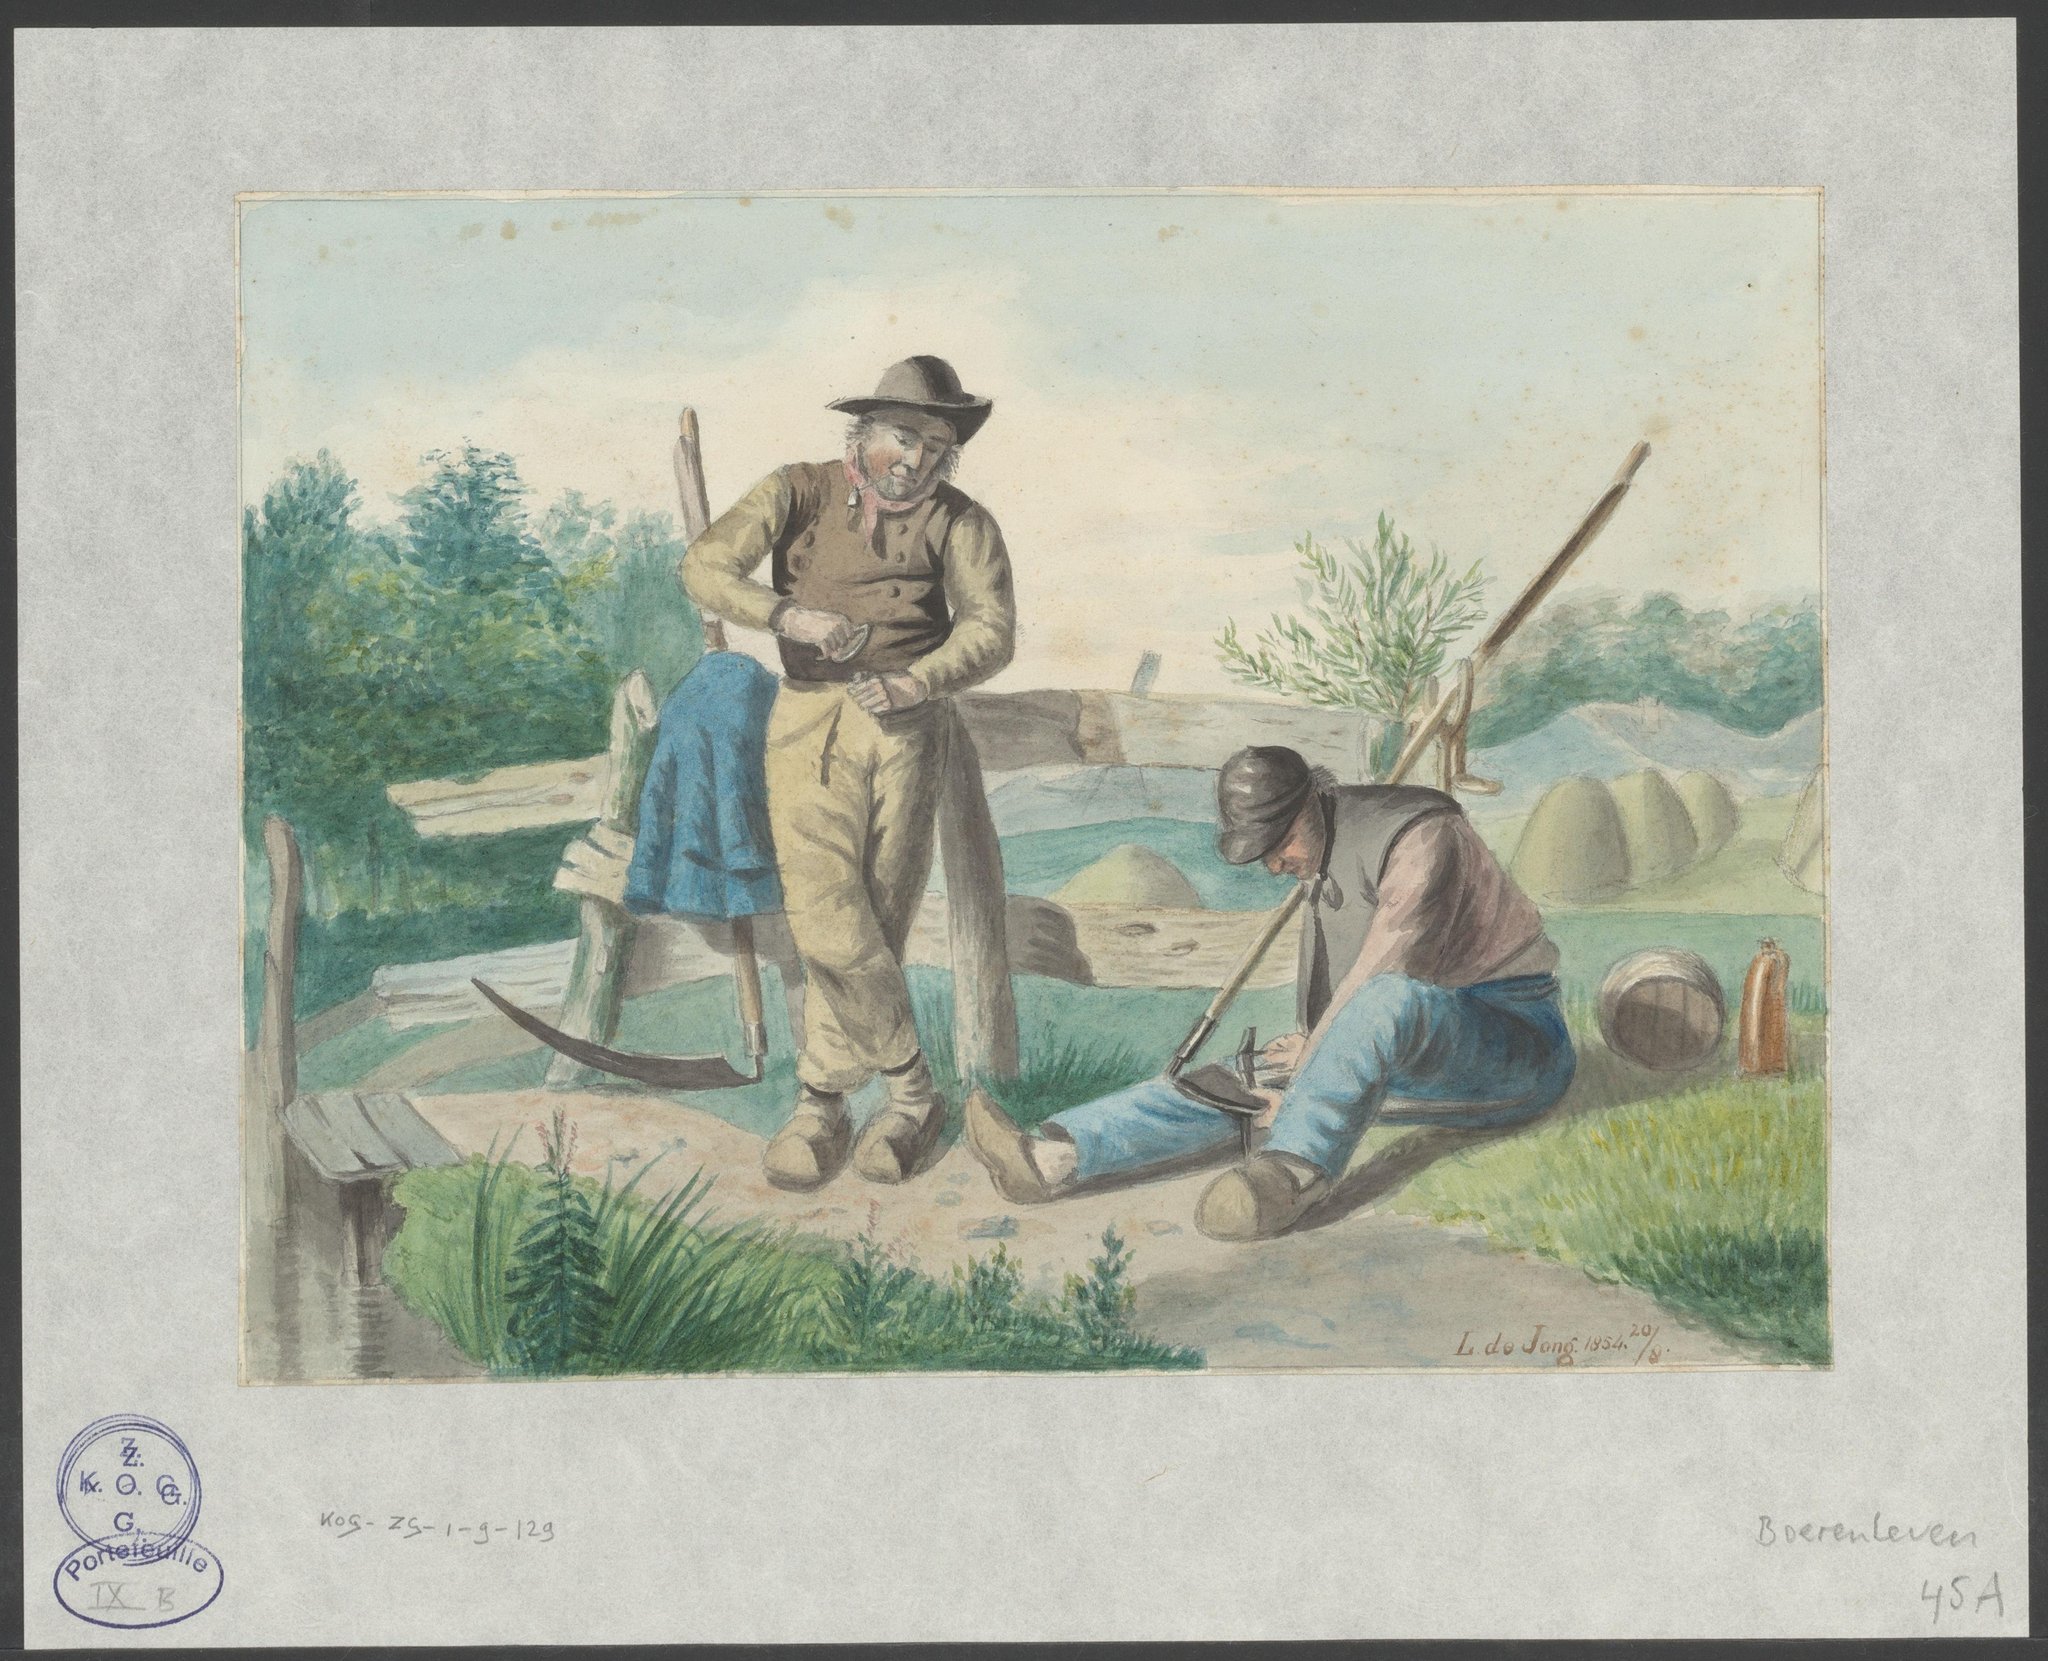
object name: drawing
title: Twee boeren wetten hun zeis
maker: Anonymous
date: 1854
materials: chalk, paper, watercolor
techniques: brush, pen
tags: agricultural implements: scythe, farmers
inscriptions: collector's mark: Lugt 1641, stamp, signature: ‘L. de Jong. 1854. 20/8’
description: Onderwerpsrubrieken binnen de Atlas Zeden en Gewoonten: Handel, nijverheid en verkeer, Boerenleven.